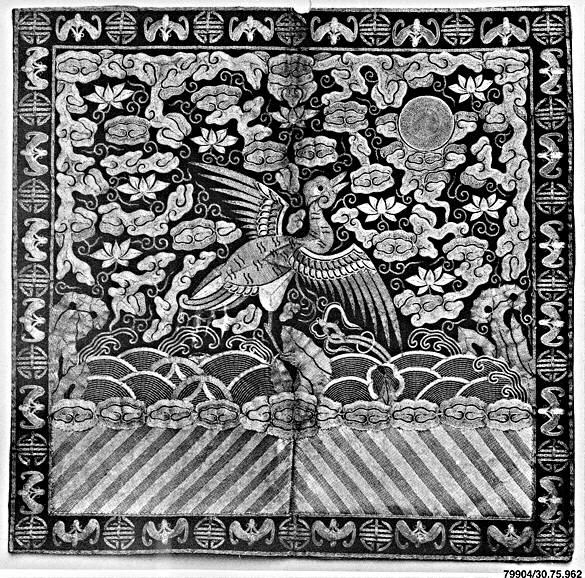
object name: rank badge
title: Rank Badge with Wild Goose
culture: chinese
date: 1767-1833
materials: metal thread, silk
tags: bats,geese